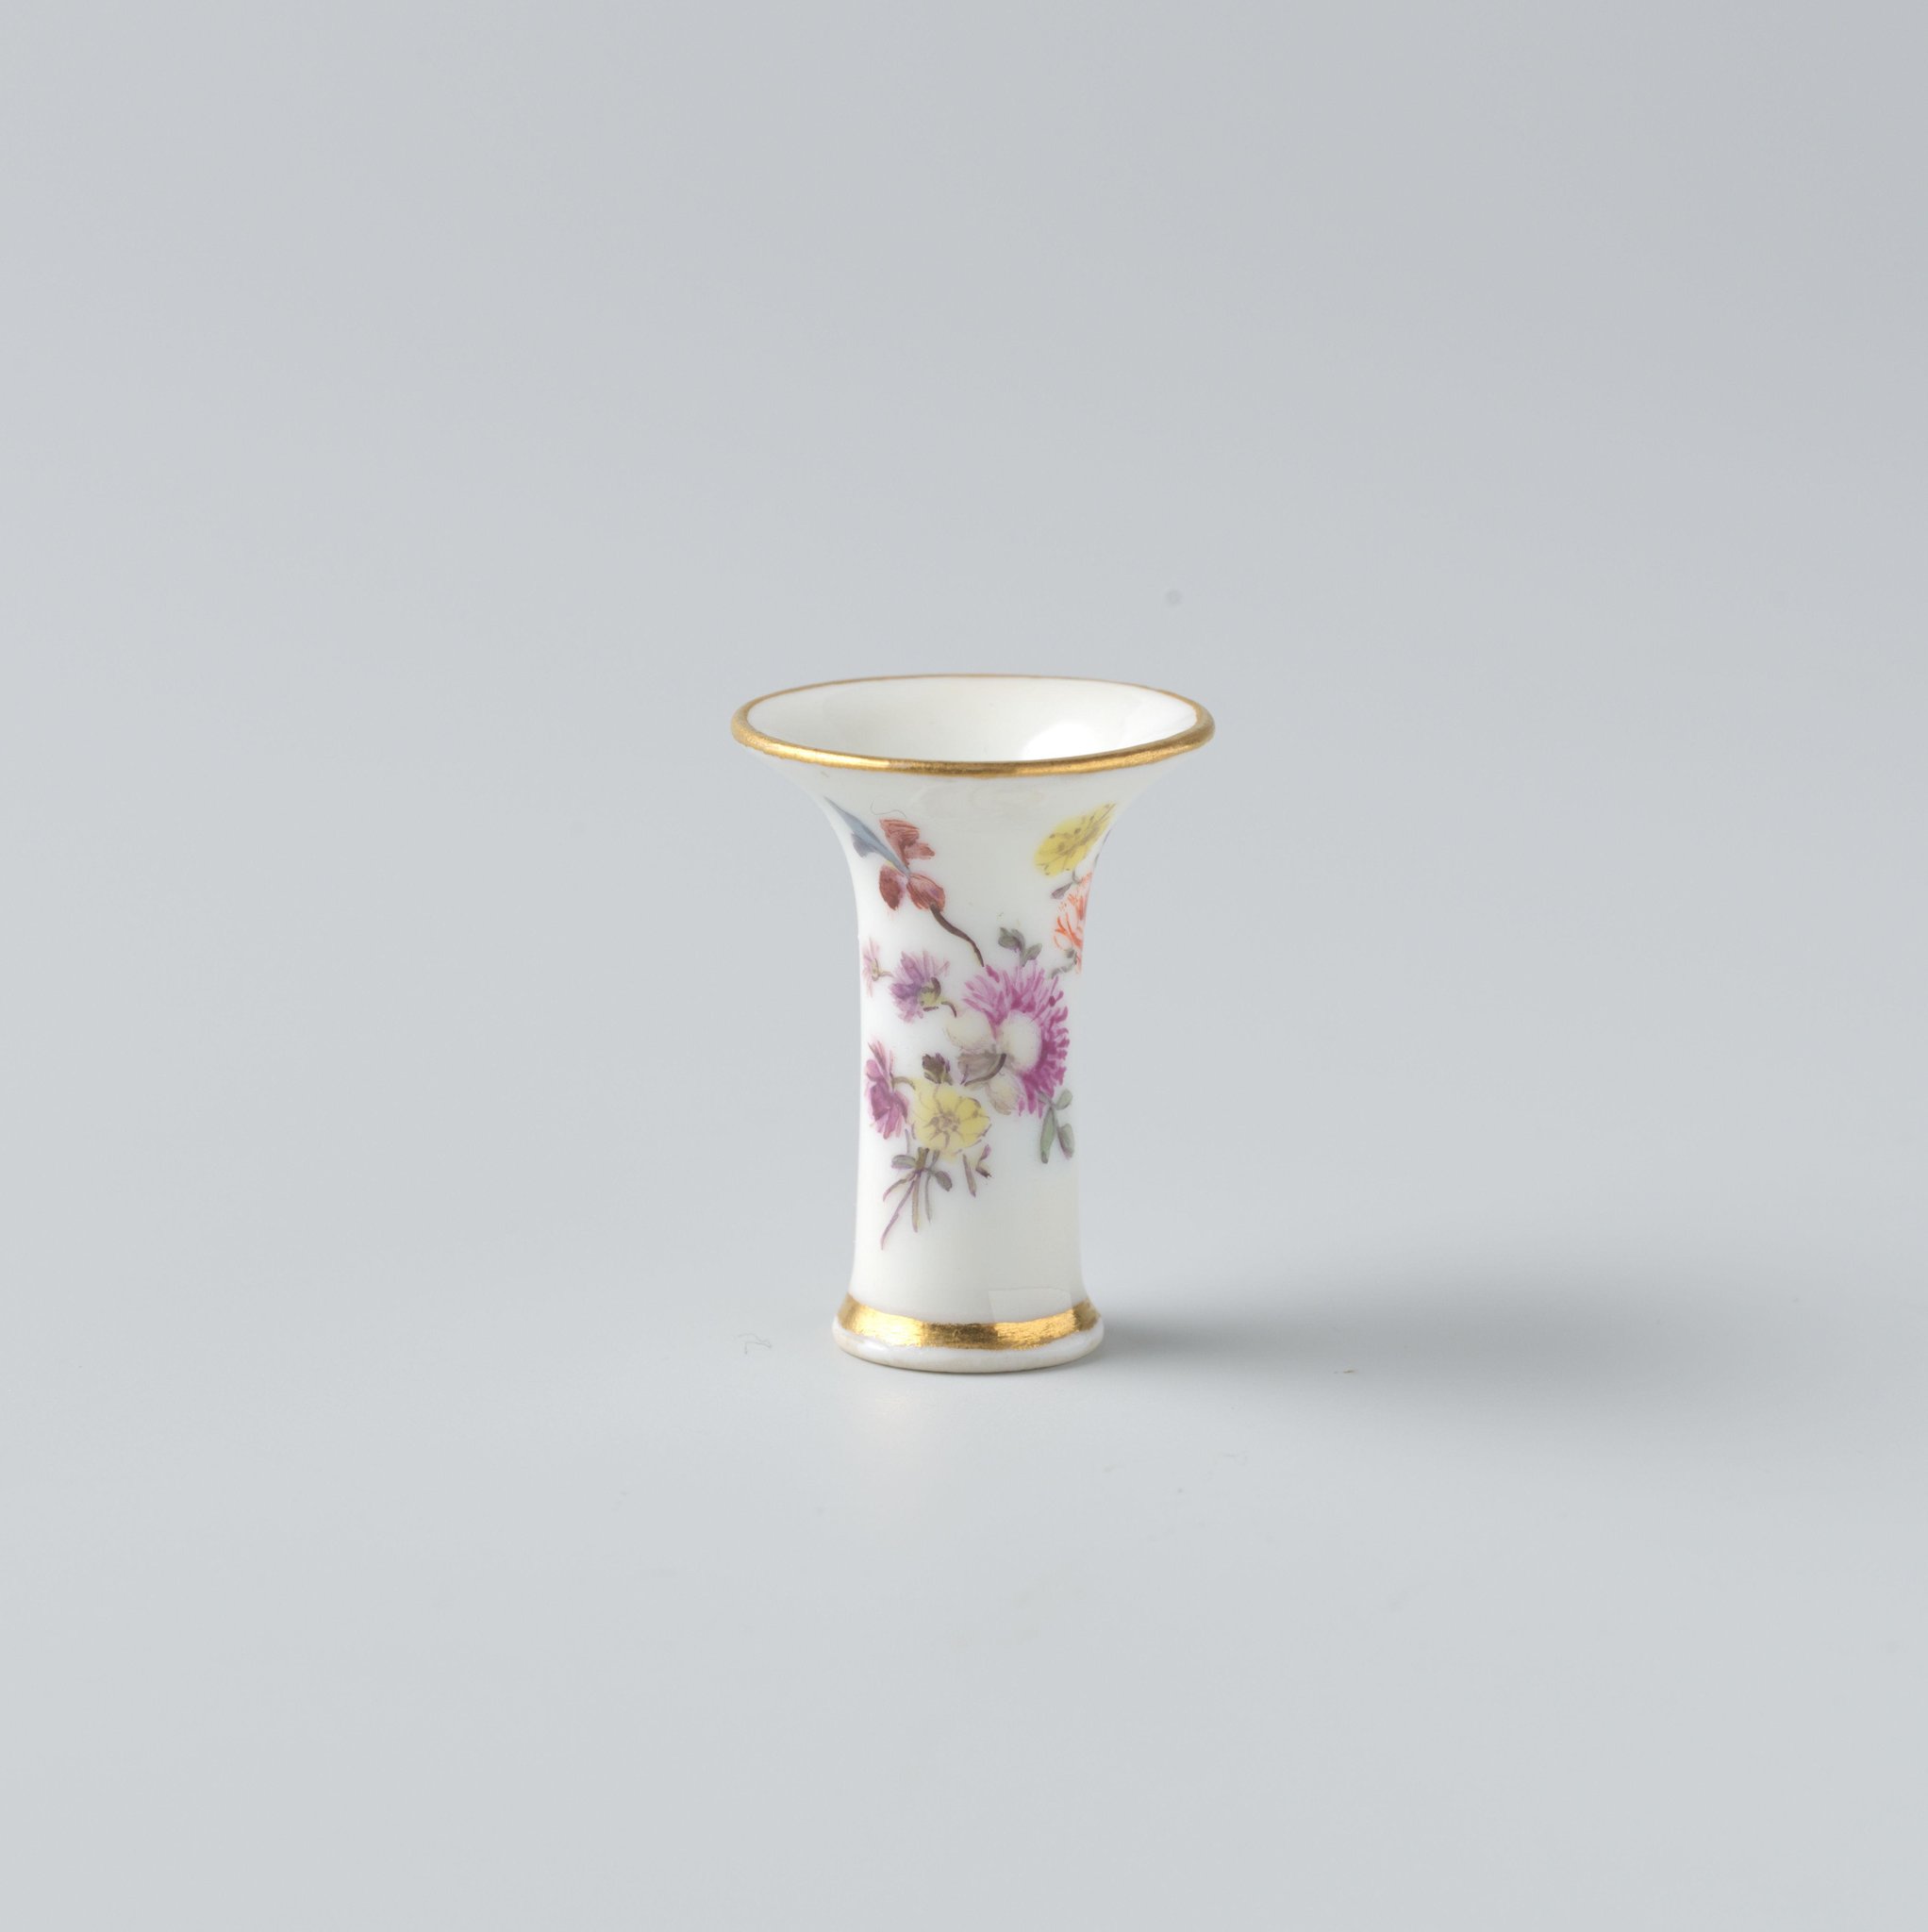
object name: miniature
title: Vaas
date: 1750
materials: porcelain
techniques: painted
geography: meissen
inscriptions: factory mark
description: Vaas van beschilderd porselein. De vaas is cilindrisch en heeft een uitstaande mondrand. De beschildering bestaat uit veelkleurige bloemboeketten. Vaas maakt deel uit van een zevendelig kaststel.